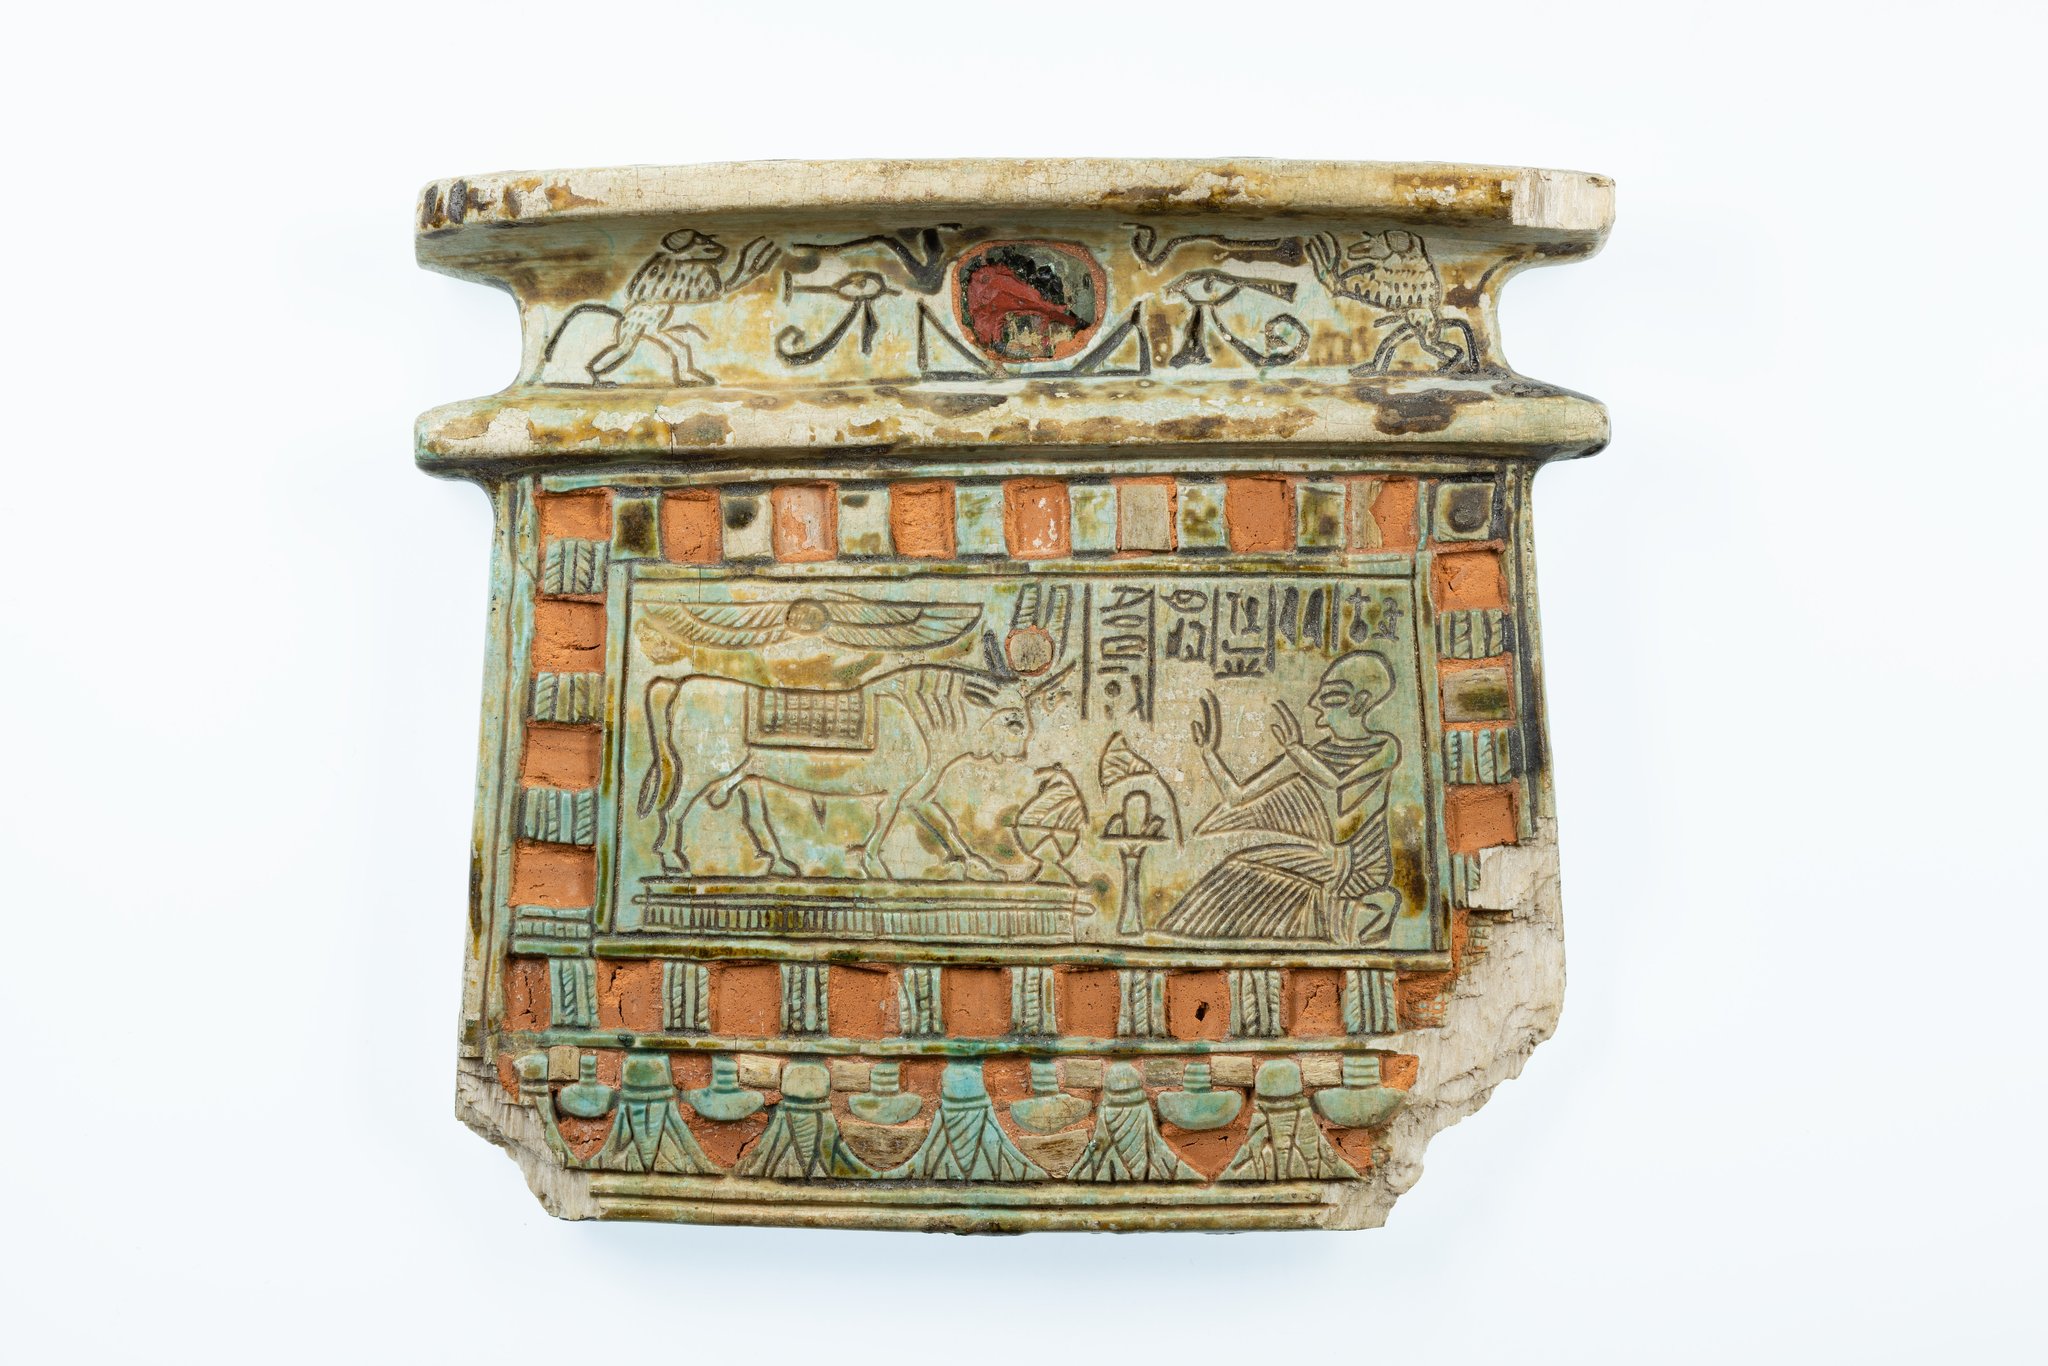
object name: pectoral, huynefer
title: Pectoral of Huynefer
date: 1295-1070 BCE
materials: faience, paste, stone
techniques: glazing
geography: southern upper egypt